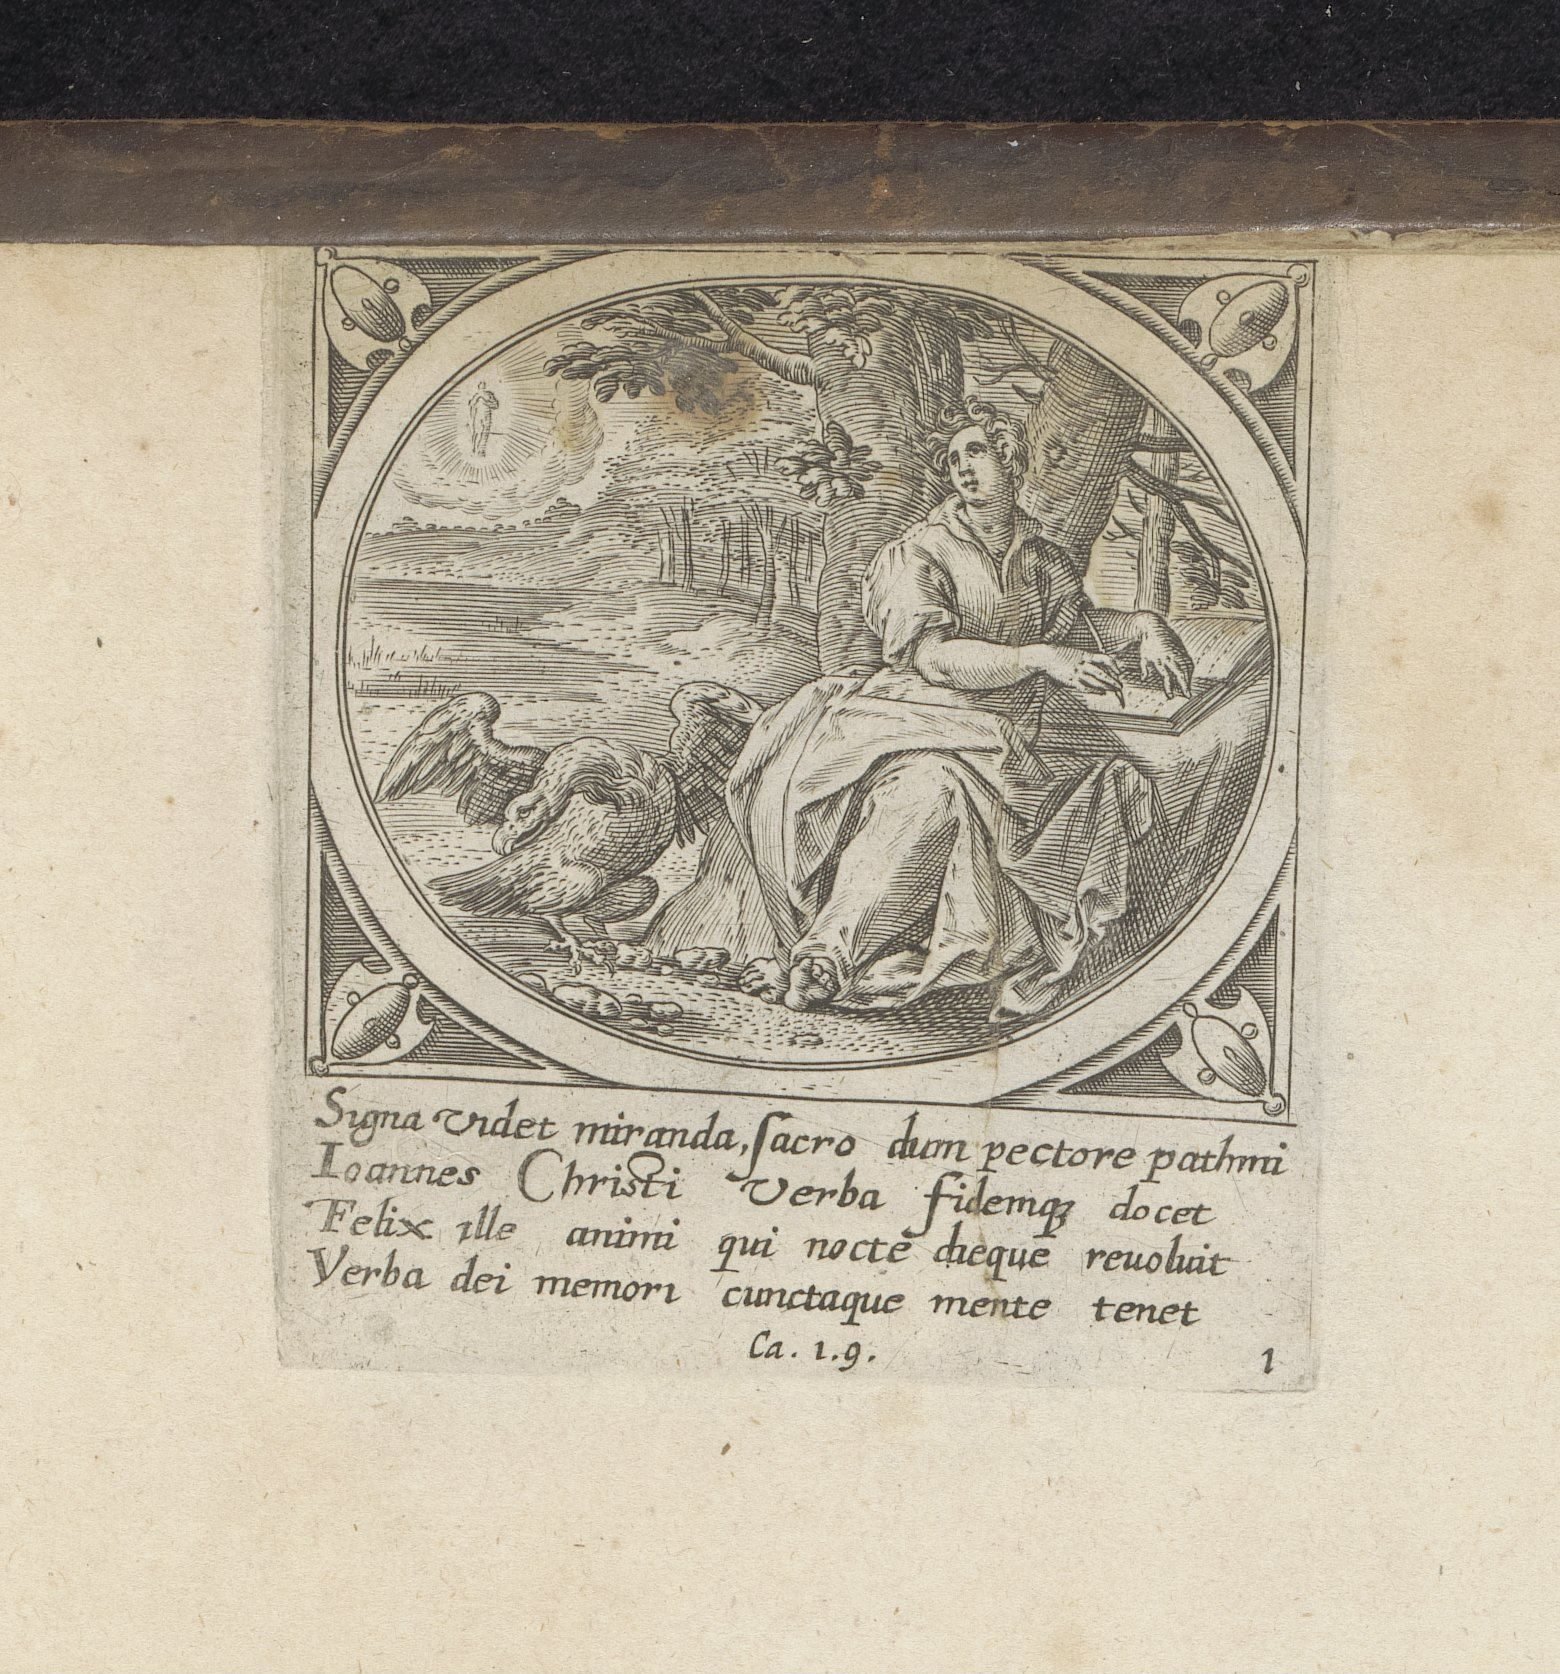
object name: print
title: Openbaring van Johannes op Patmos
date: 1585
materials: paper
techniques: engraving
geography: alkmaar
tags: john (writing) on the island of patmos, possibly the eagle beside him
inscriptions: number: ‘207’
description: Johannes de evangelist schrijft op het eiland Patmos zijn openbaringen in een boek. Hij kijkt omhoog naar de hemel naar een verschijning van Christus. Naast Johannes zit de adelaar. Onder de voorstelling een verwijzing in het Latijn naar de Bijbeltekst. Deze prent maakt deel uit van een album.